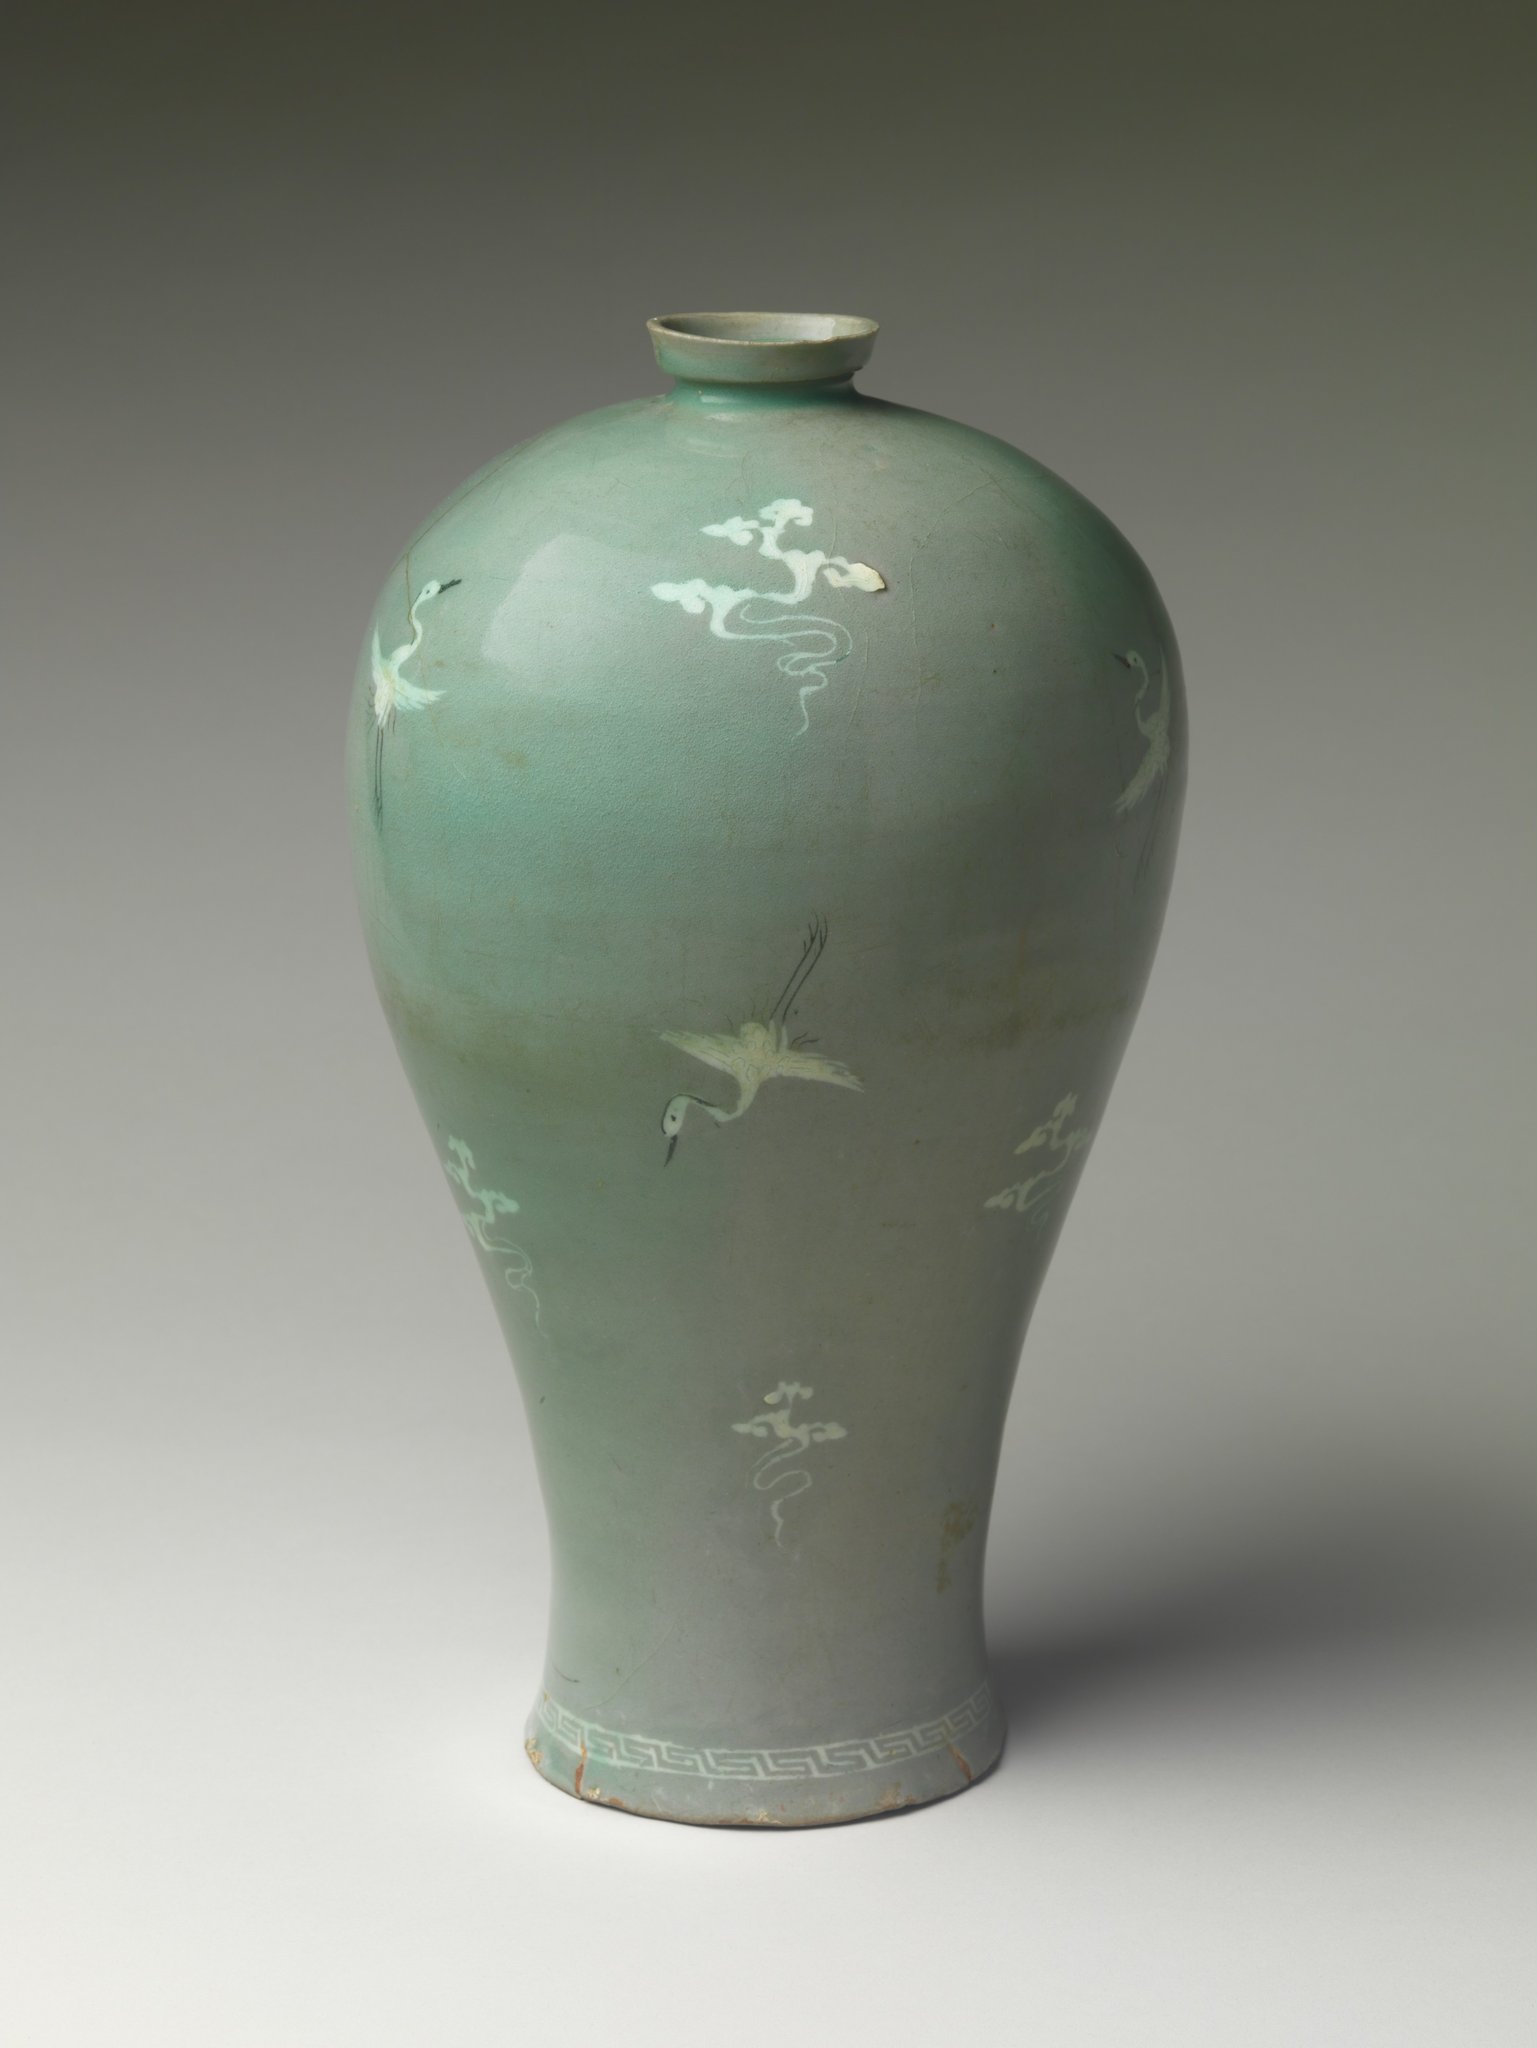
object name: vase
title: Maebyeong (plum bottle) decorated with cranes and clouds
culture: korean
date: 1151-1200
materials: ceramic glaze, glaze, stoneware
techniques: inlay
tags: cranes